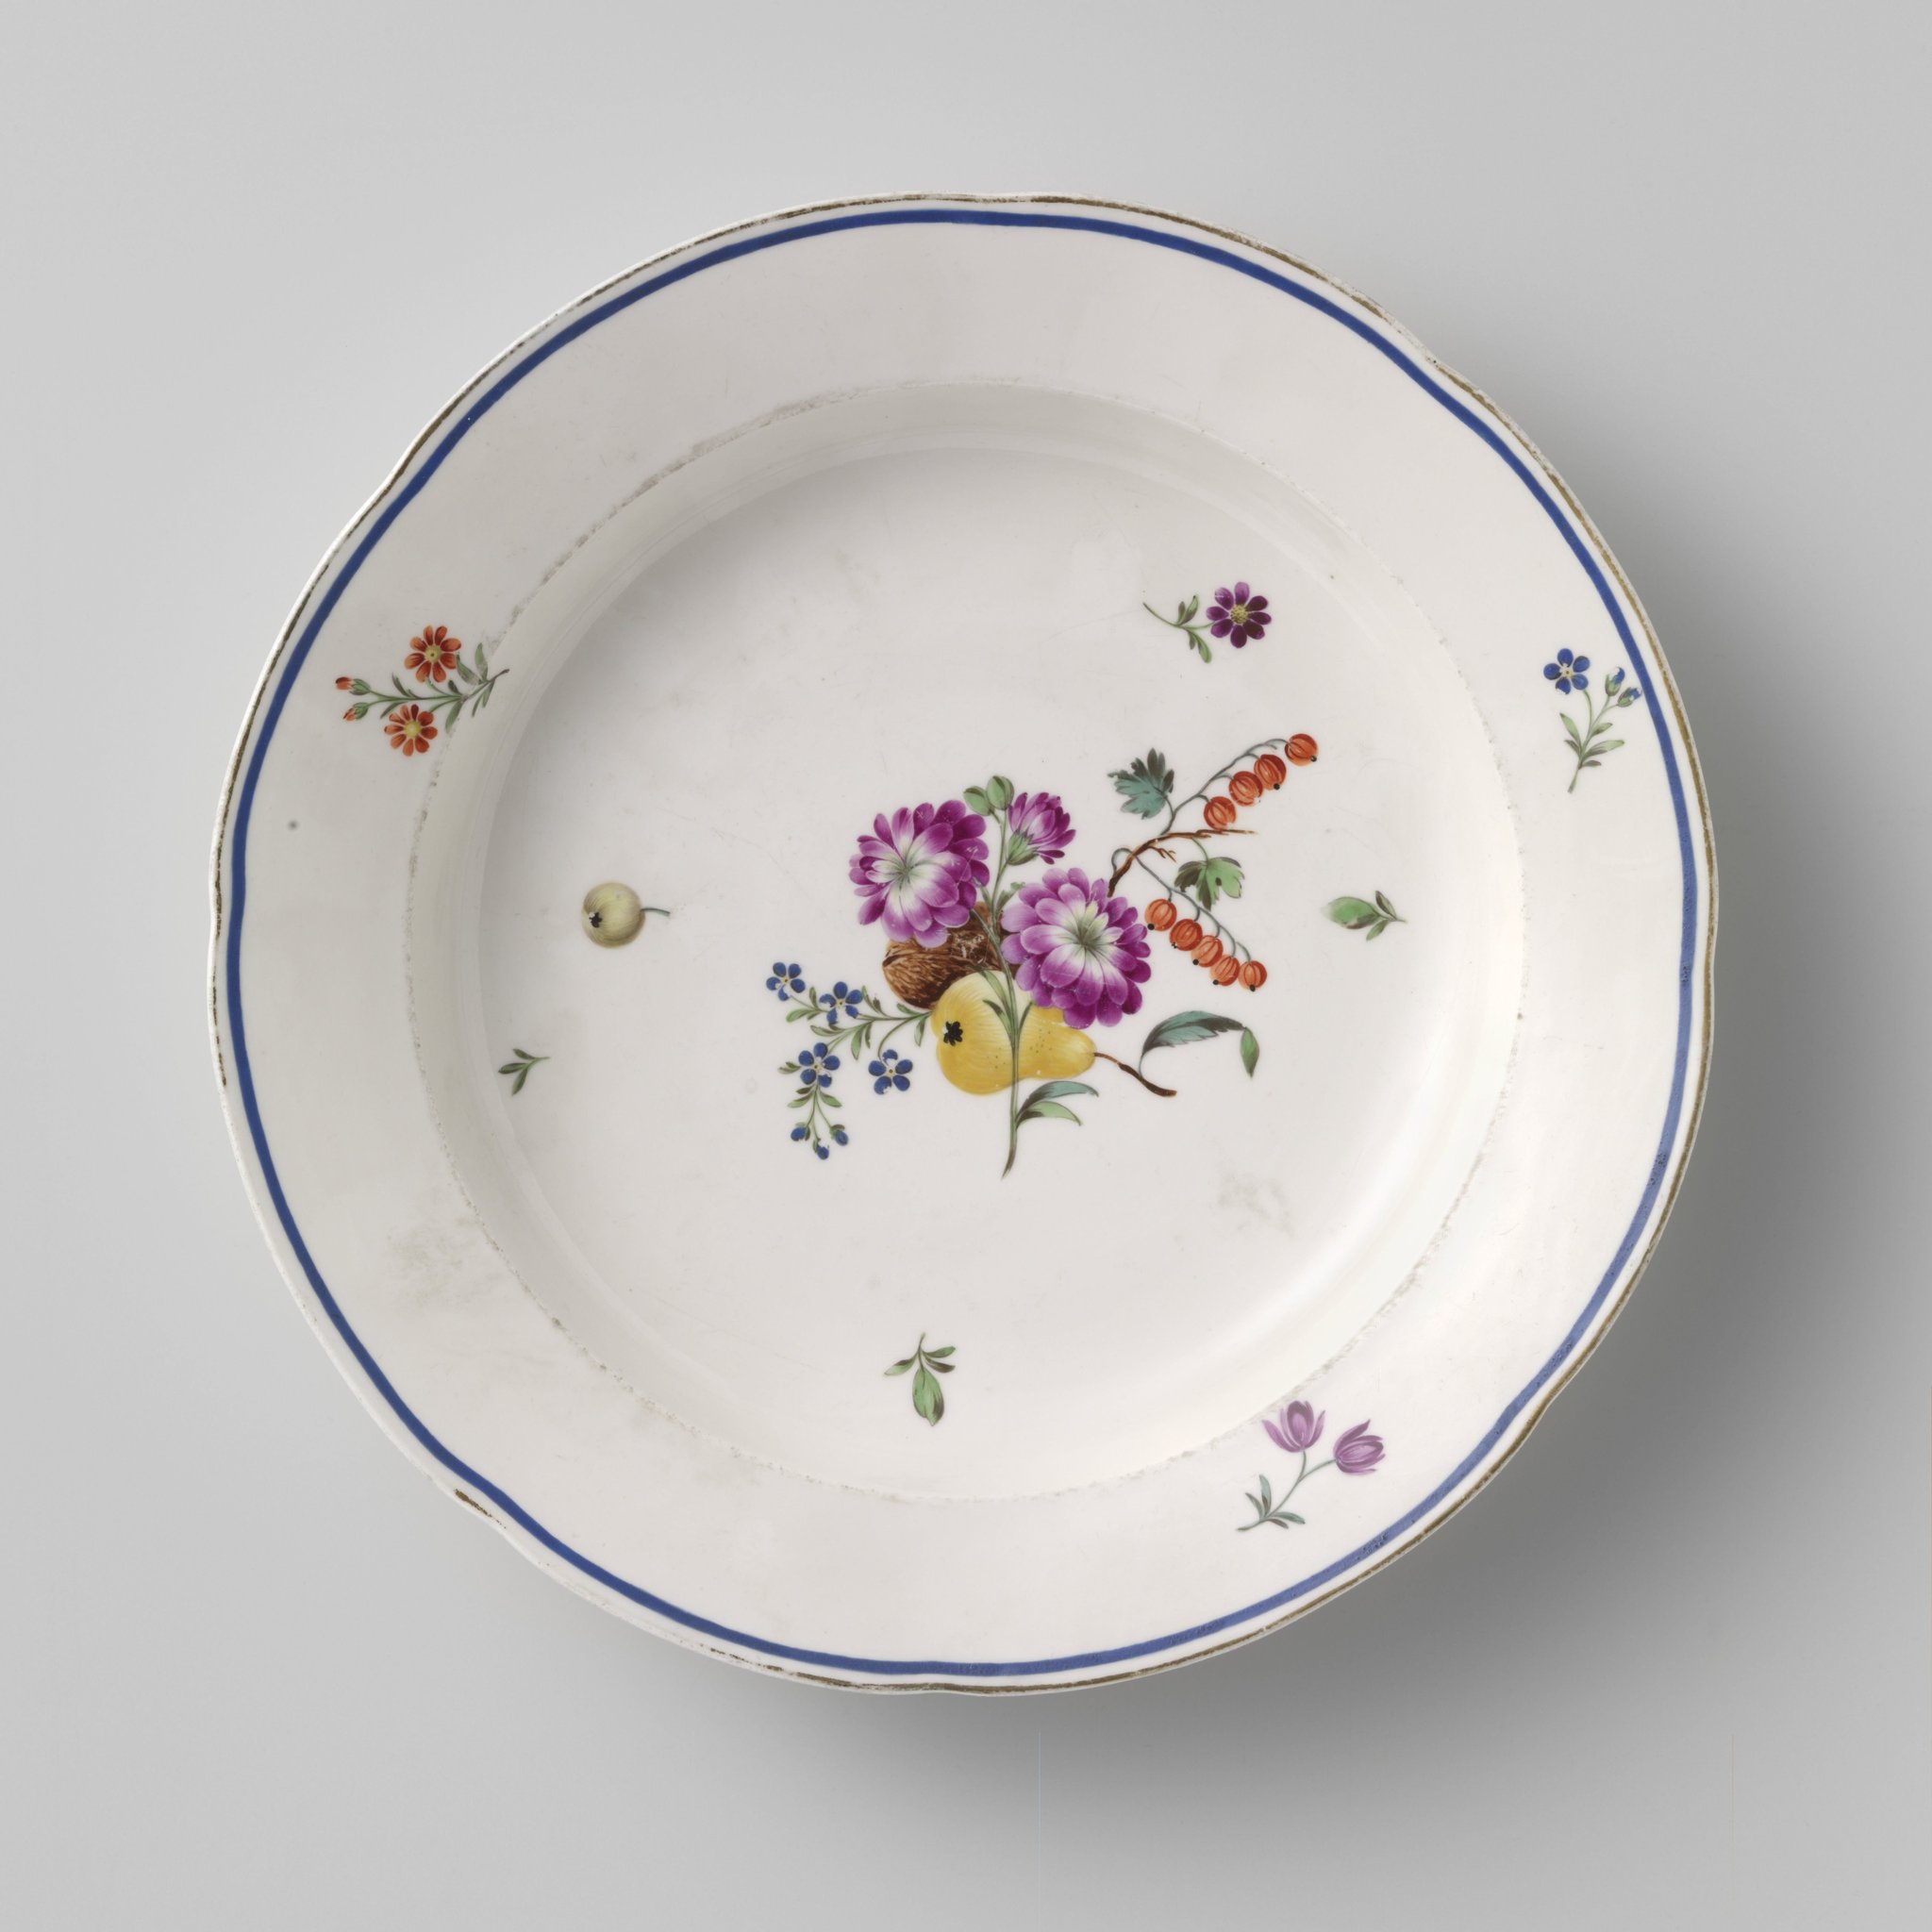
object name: plate dish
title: Plate with a bouquets and flowers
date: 1762-1795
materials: glaze, gold, paint, porcelain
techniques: firing, forming, gilding, turning, vitrification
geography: frankenthal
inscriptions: mark: ‘gekroonde CT/ III/ 46/ F/ H0’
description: Diep bord van porselein, beschilderd op het glazuur in blauw, rood, roze, groen, geel, zwart, bruin en goud. Op het plat een boeket van verschillende bloemen en een kokosnoot[?]. Om het boeket en op de rand strooibloemen. Het buitenste deel van de rand met een blauwe en gouden lijn. Gemerkt op de onderzijde met de gekroonde CT waaronder III, 46, F en H0.